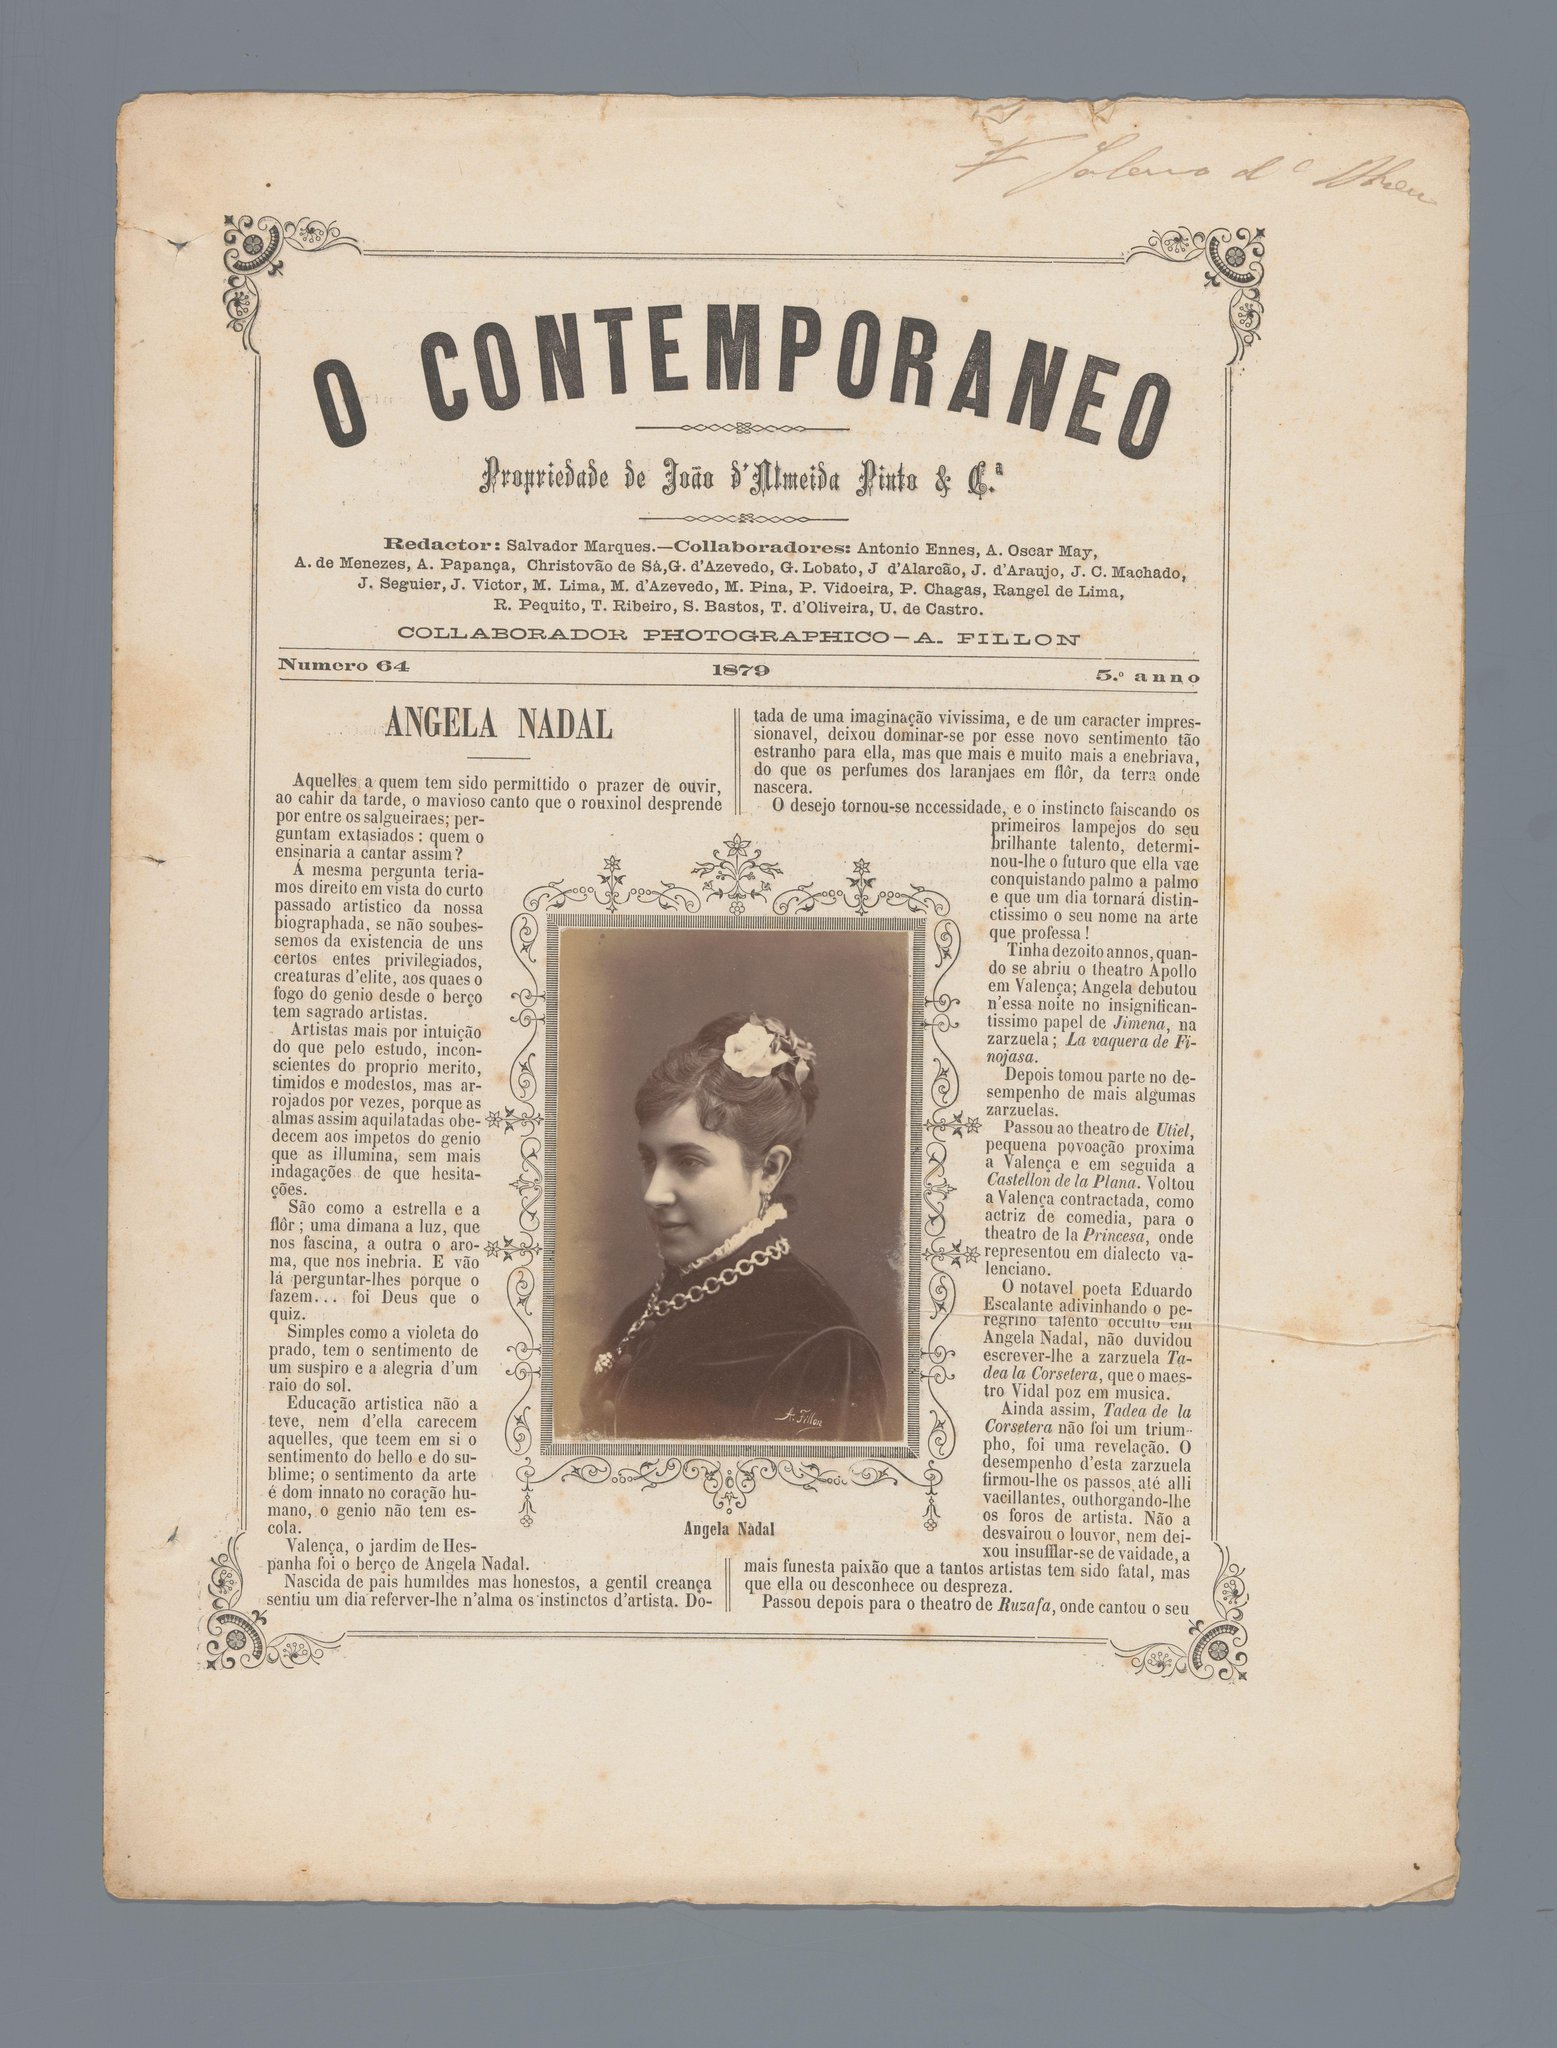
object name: magazine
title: O contemporaneo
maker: alfred fillon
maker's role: fotograaf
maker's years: 1825-1881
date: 1874-1879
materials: paper, photographic support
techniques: albumen print, printing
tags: historical persons - bb - woman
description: Op de voorpagina bevindt zich een portret van Angela Nadal.